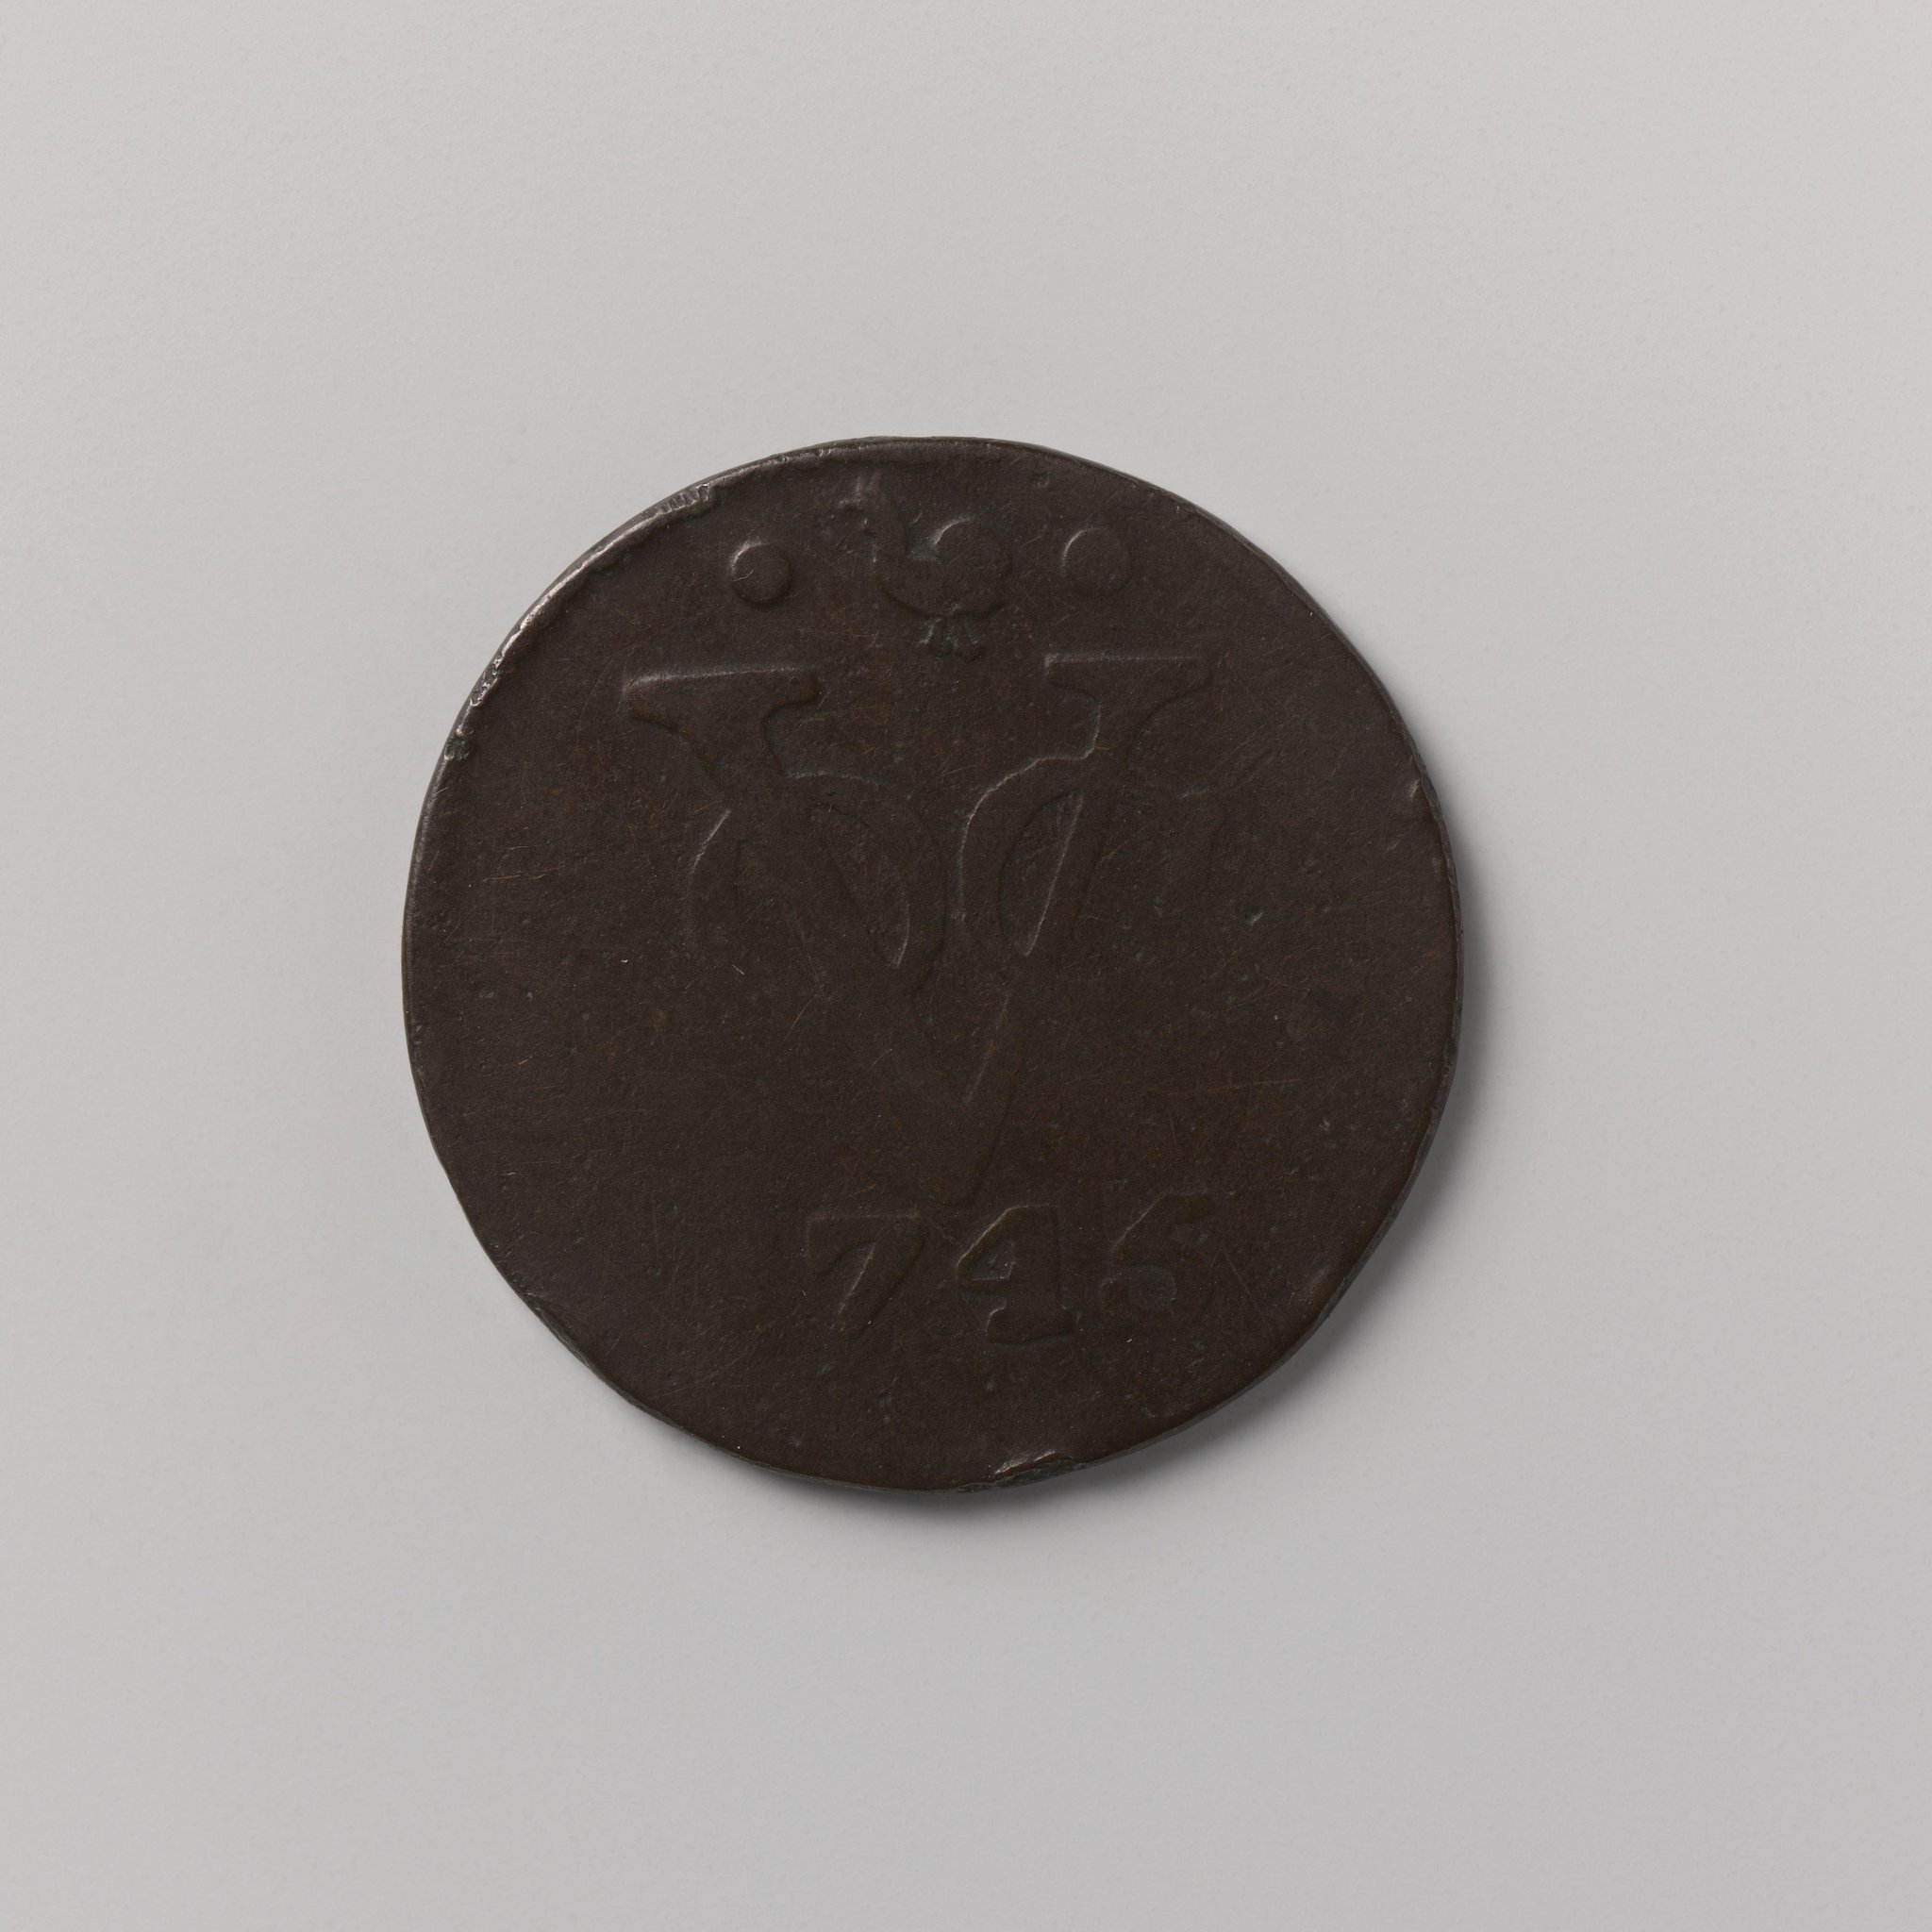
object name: coin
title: Duit van de VOC uit Westfriesland, 1745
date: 1745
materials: copper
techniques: striking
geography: medemblik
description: Koperen munt. Voorzijde: gekroond wapenschild van Westfriesland. Keerzijde: monogram van de VOC, waarboven muntmeesterteken en waaronder jaartal. Gladde rand.